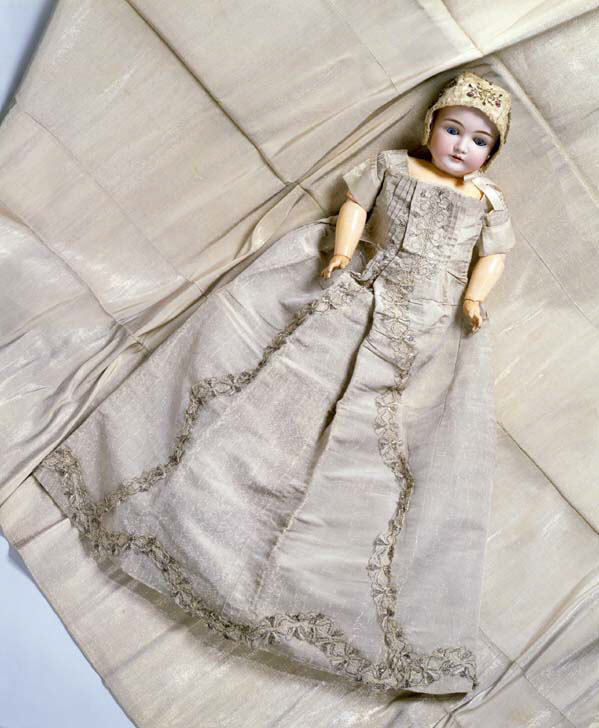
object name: christening ensemble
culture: british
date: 1710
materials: silk, silver